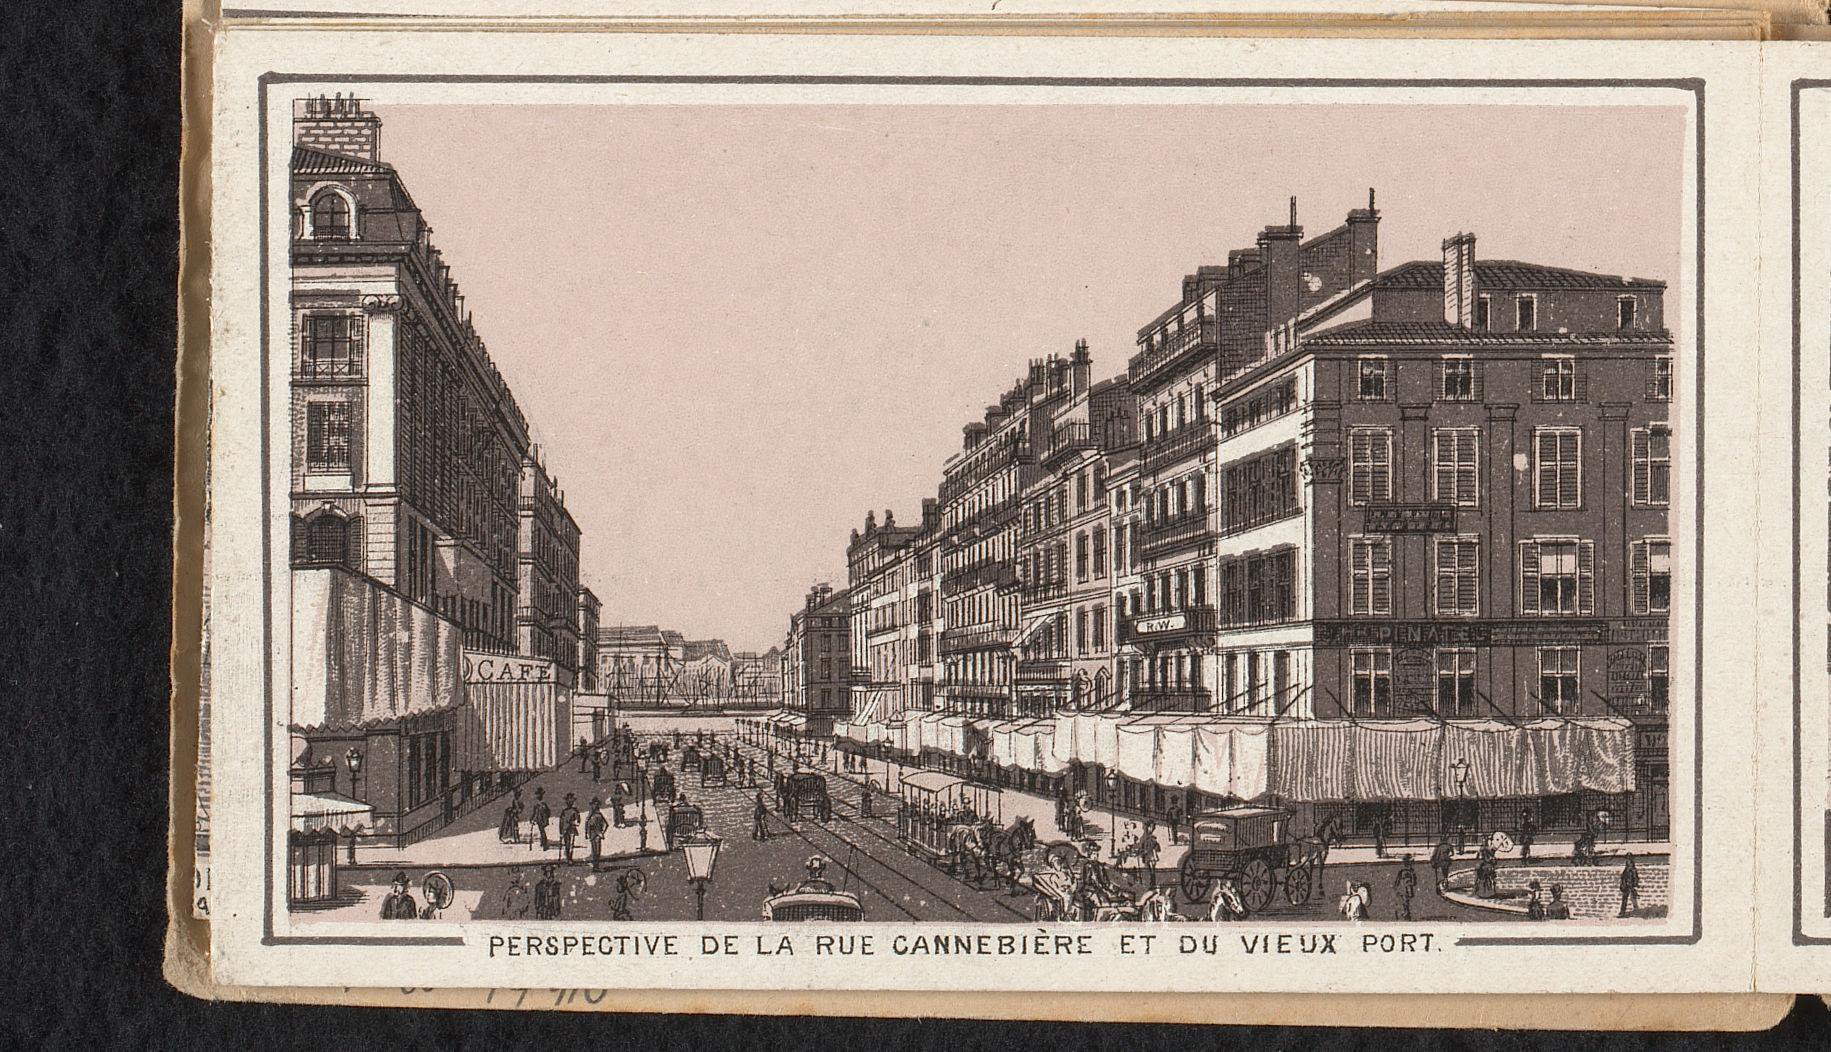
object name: print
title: Perspective de la Rue Cannebière et du Vieux Port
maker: Anonymous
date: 1890-1910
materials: cardboard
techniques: lithograph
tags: harbour, city-view, and landscape with man-made constructions (+ city(-scape) with figures, staffage), marseille